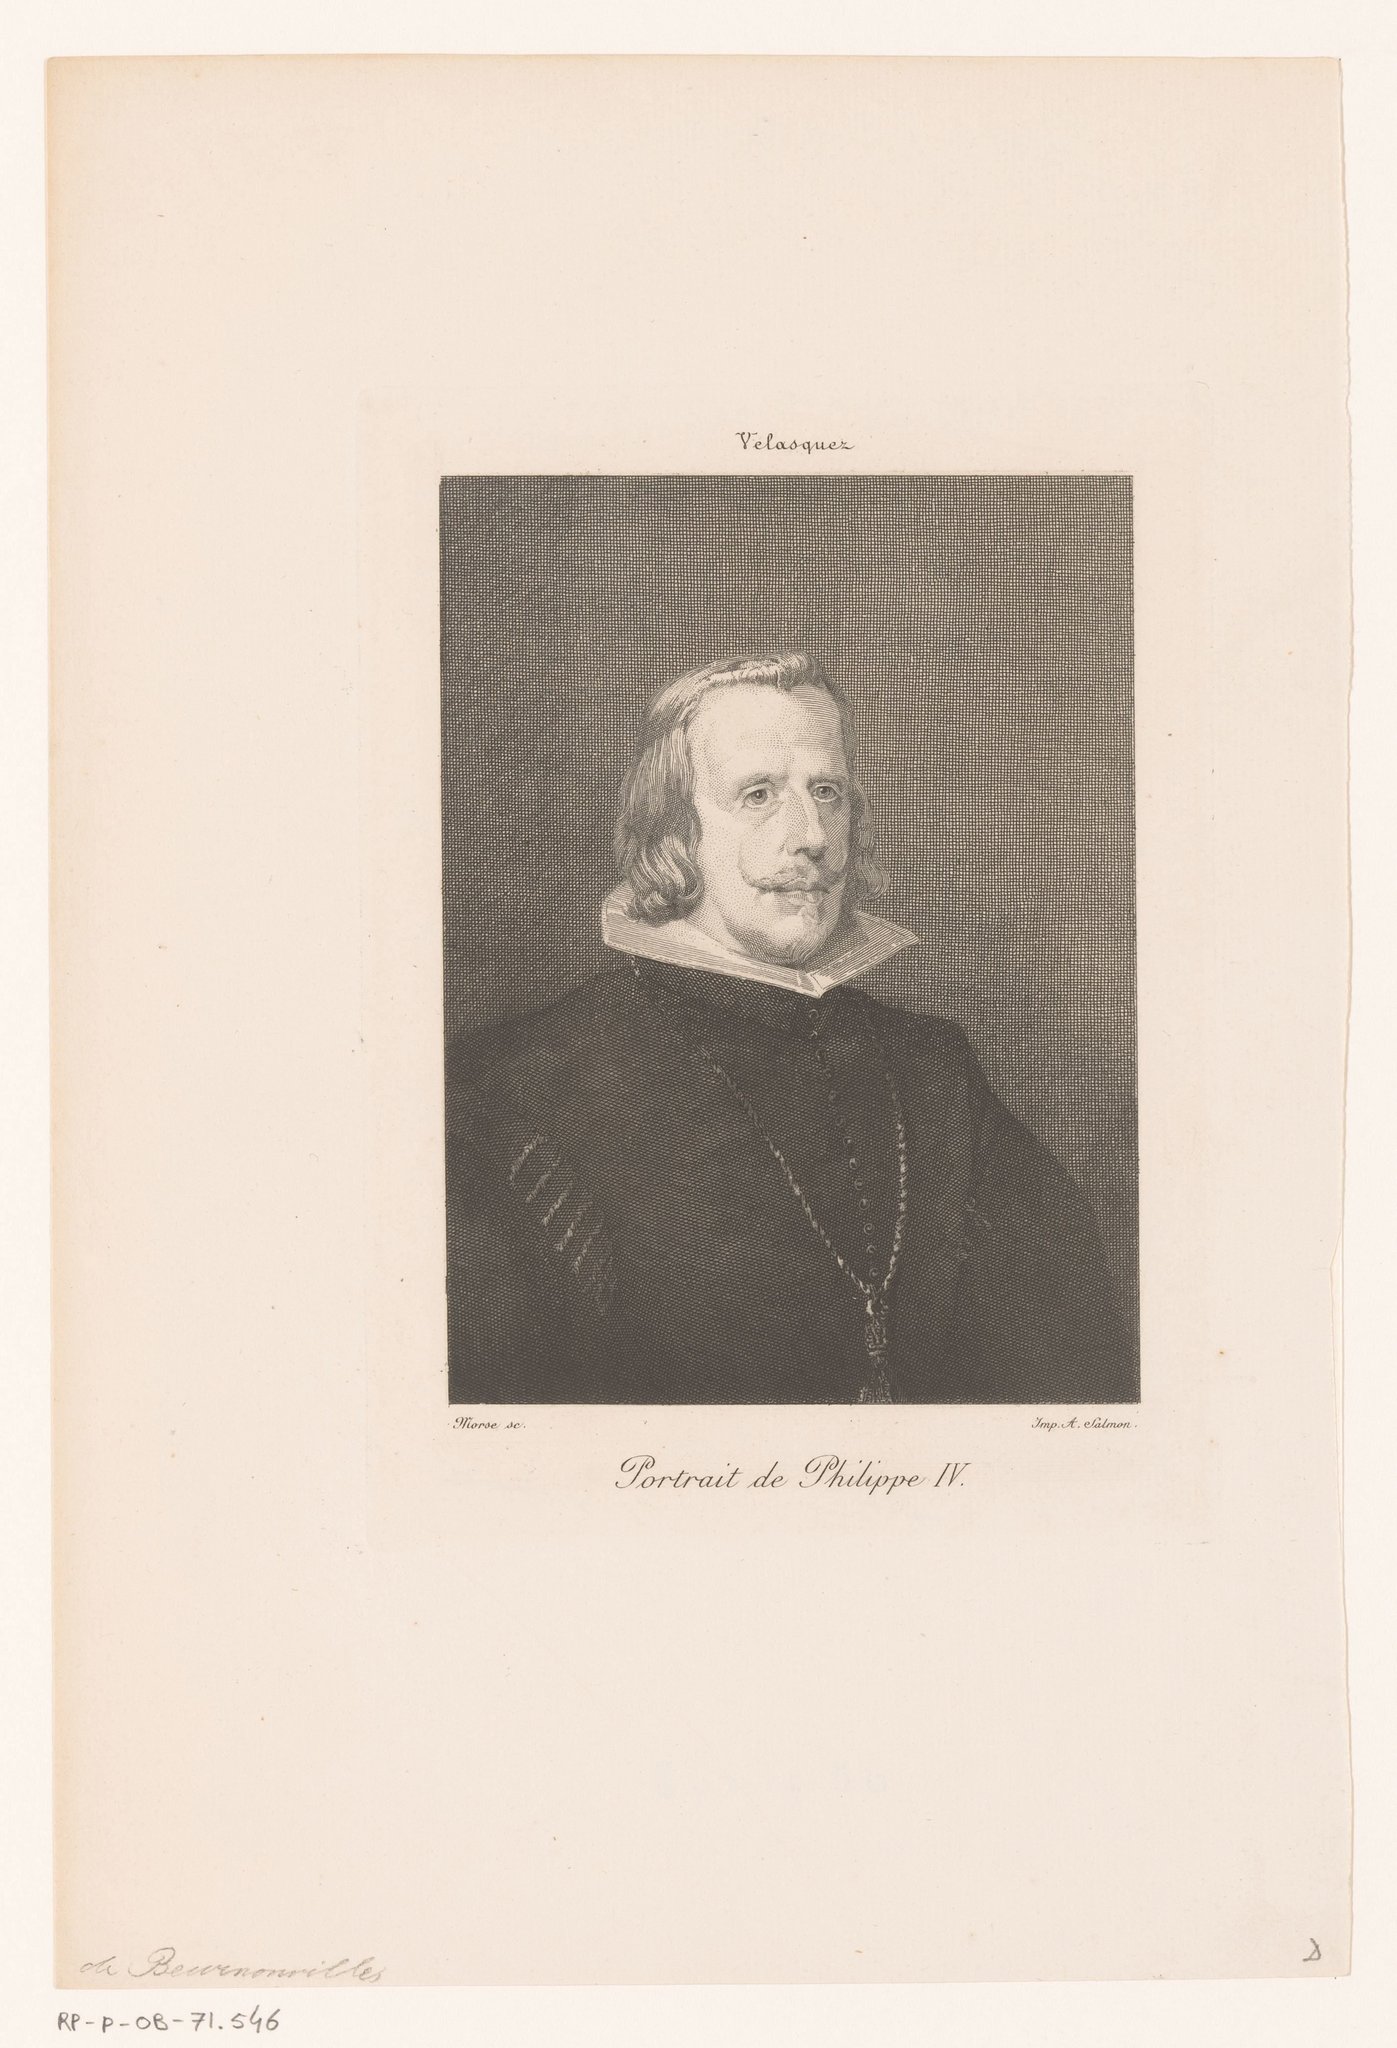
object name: print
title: Portrait de Philippe IV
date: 1881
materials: paper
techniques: etching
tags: filips iv (koning van spanje), historical persons, king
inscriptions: collector's mark: Lugt 2228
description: Prent afkomstig uit een veilingcatalogus: "Catalogue des Tableaux anciens composant la très importante collection de Monsieur le Baron de Beurnonville", uitgegeven in 1881 te Parijs door Pillet en Dumoulin. De veiling vond plaats op 9 tot en met 14 en 16 mei 1881.